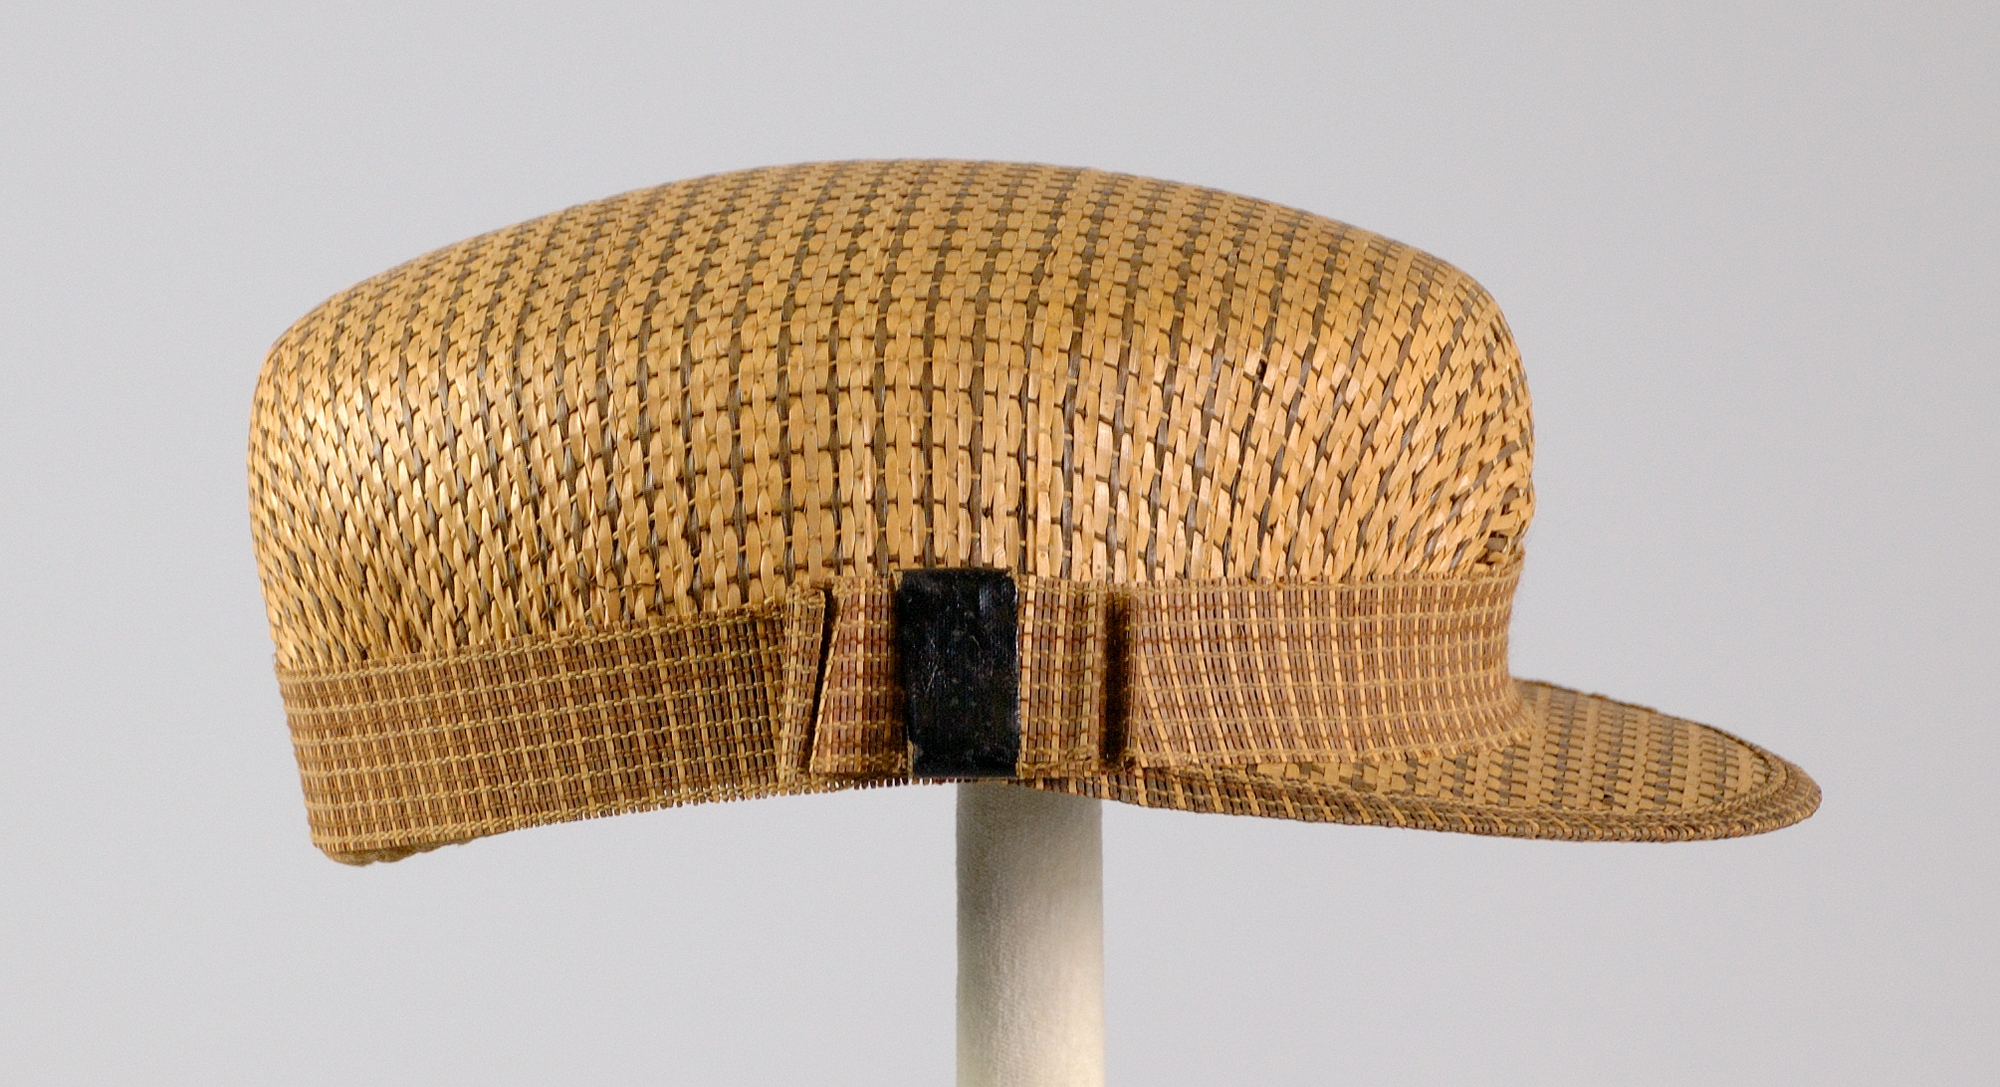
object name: cap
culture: american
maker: excelsior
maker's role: maker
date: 1890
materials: leather, fiber